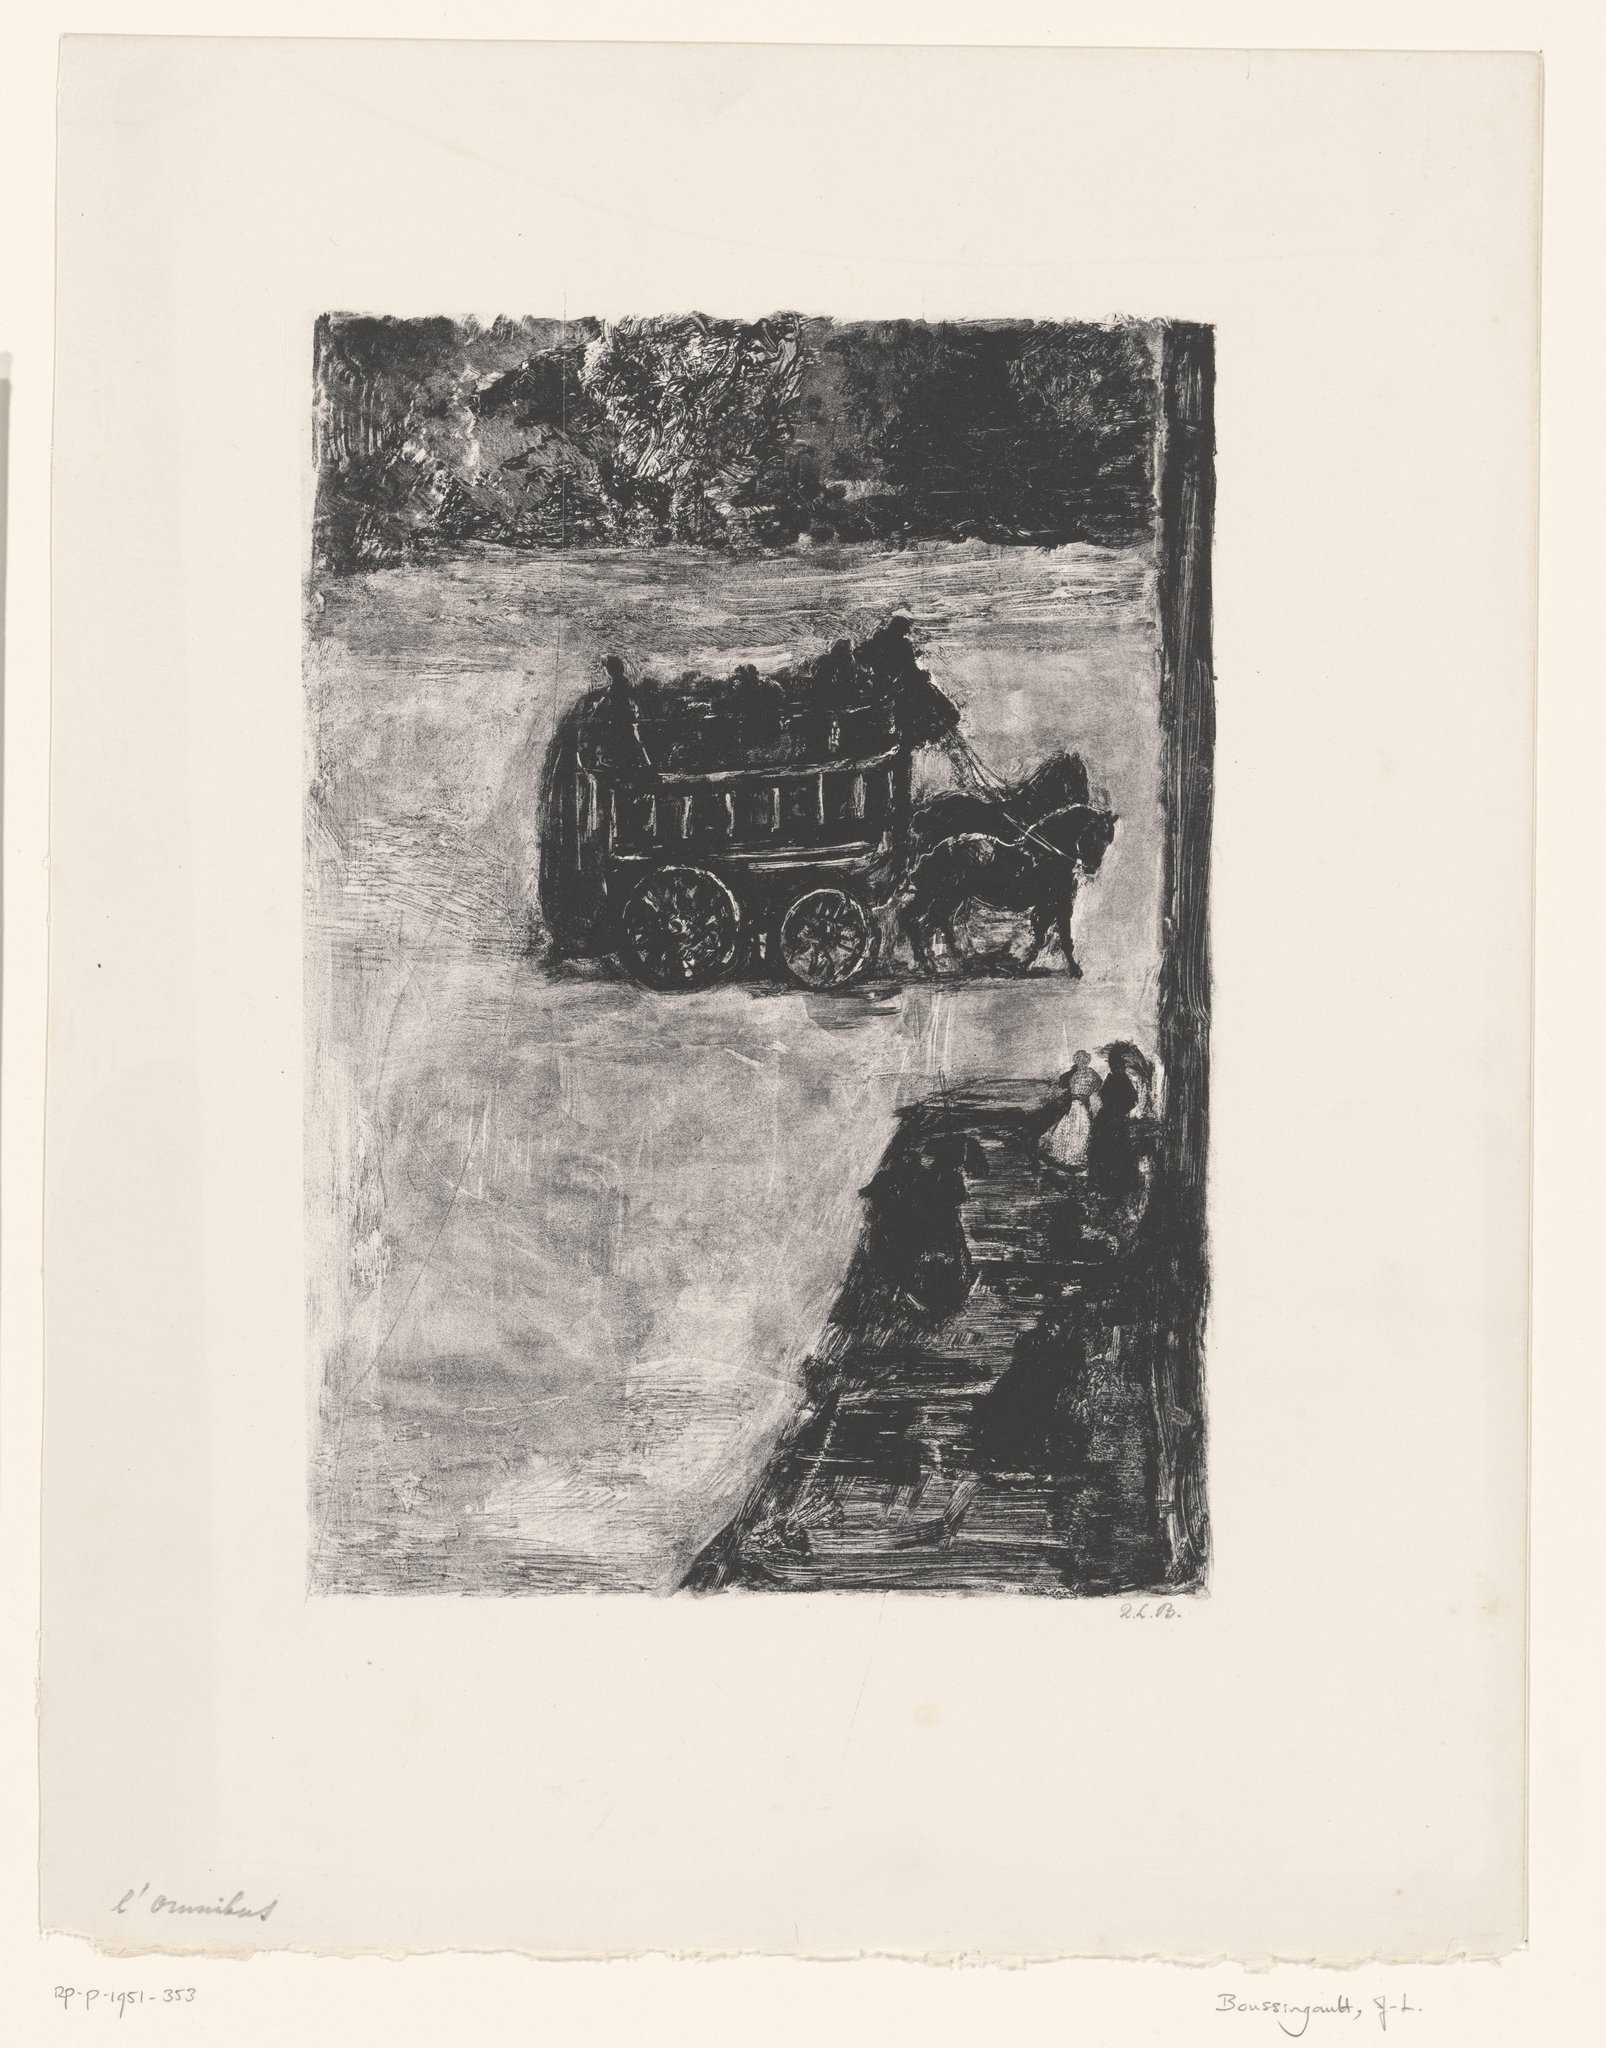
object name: print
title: L'Omnibus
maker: jean-louis boussingault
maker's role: painter, print maker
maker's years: 1883-1943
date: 1893-1943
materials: paper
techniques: lithograph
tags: diligence, omnibus, horse-tram, street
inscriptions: collector's mark: Lugt 2228